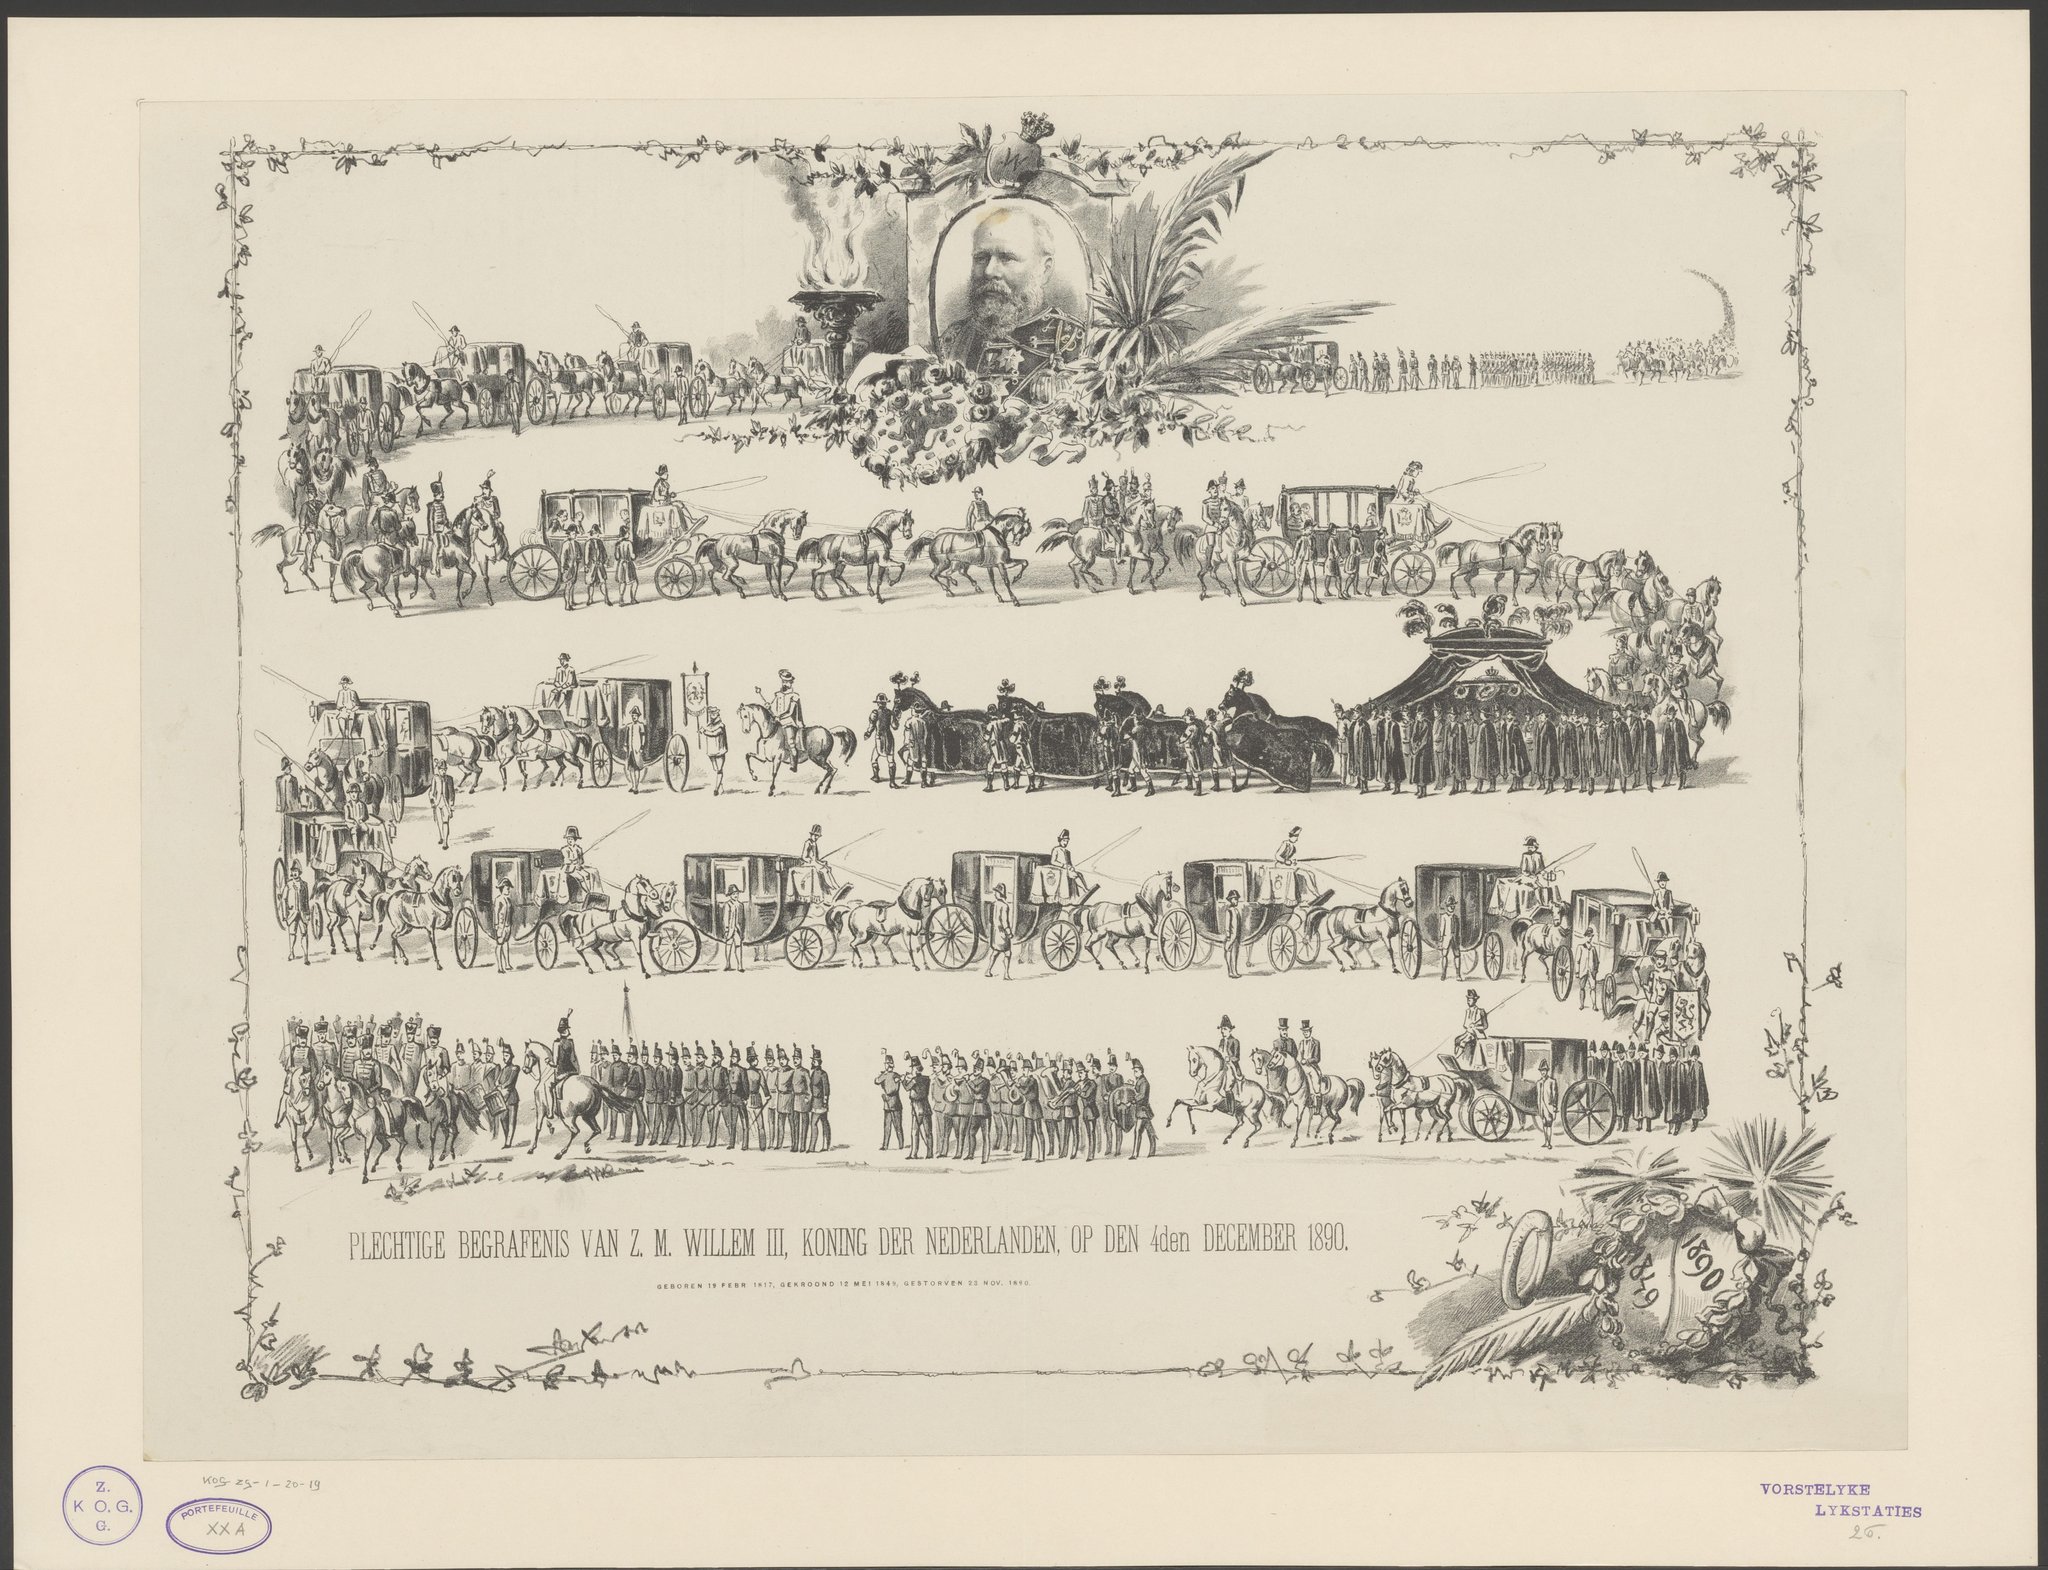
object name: print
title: Begrafenisstoet voor Willem III, koning der Nederlanden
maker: Anonymous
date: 1890-1891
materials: paper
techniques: lithograph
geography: amsterdam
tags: brussels, willem iii (koning der nederlanden), cortege, funeral procession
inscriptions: collector's mark: Lugt 1641, stamp, stamp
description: Begrafenisoptocht van koning Willem III op 4 december 1890. De stoet afgebeeld in vijf rijen onder elkaar. Bovenaan een portret van de koning, rechtsonder in de hoek een rouwkrans met de jaartallen 1849 en 1890. Onderwerpsrubrieken binnen de Atlas Zeden en Gewoonten: Zeden en Gewoonten in Engeren Zin, Des menschen beging, midden en einde, Vorstelijke lijkstaties.